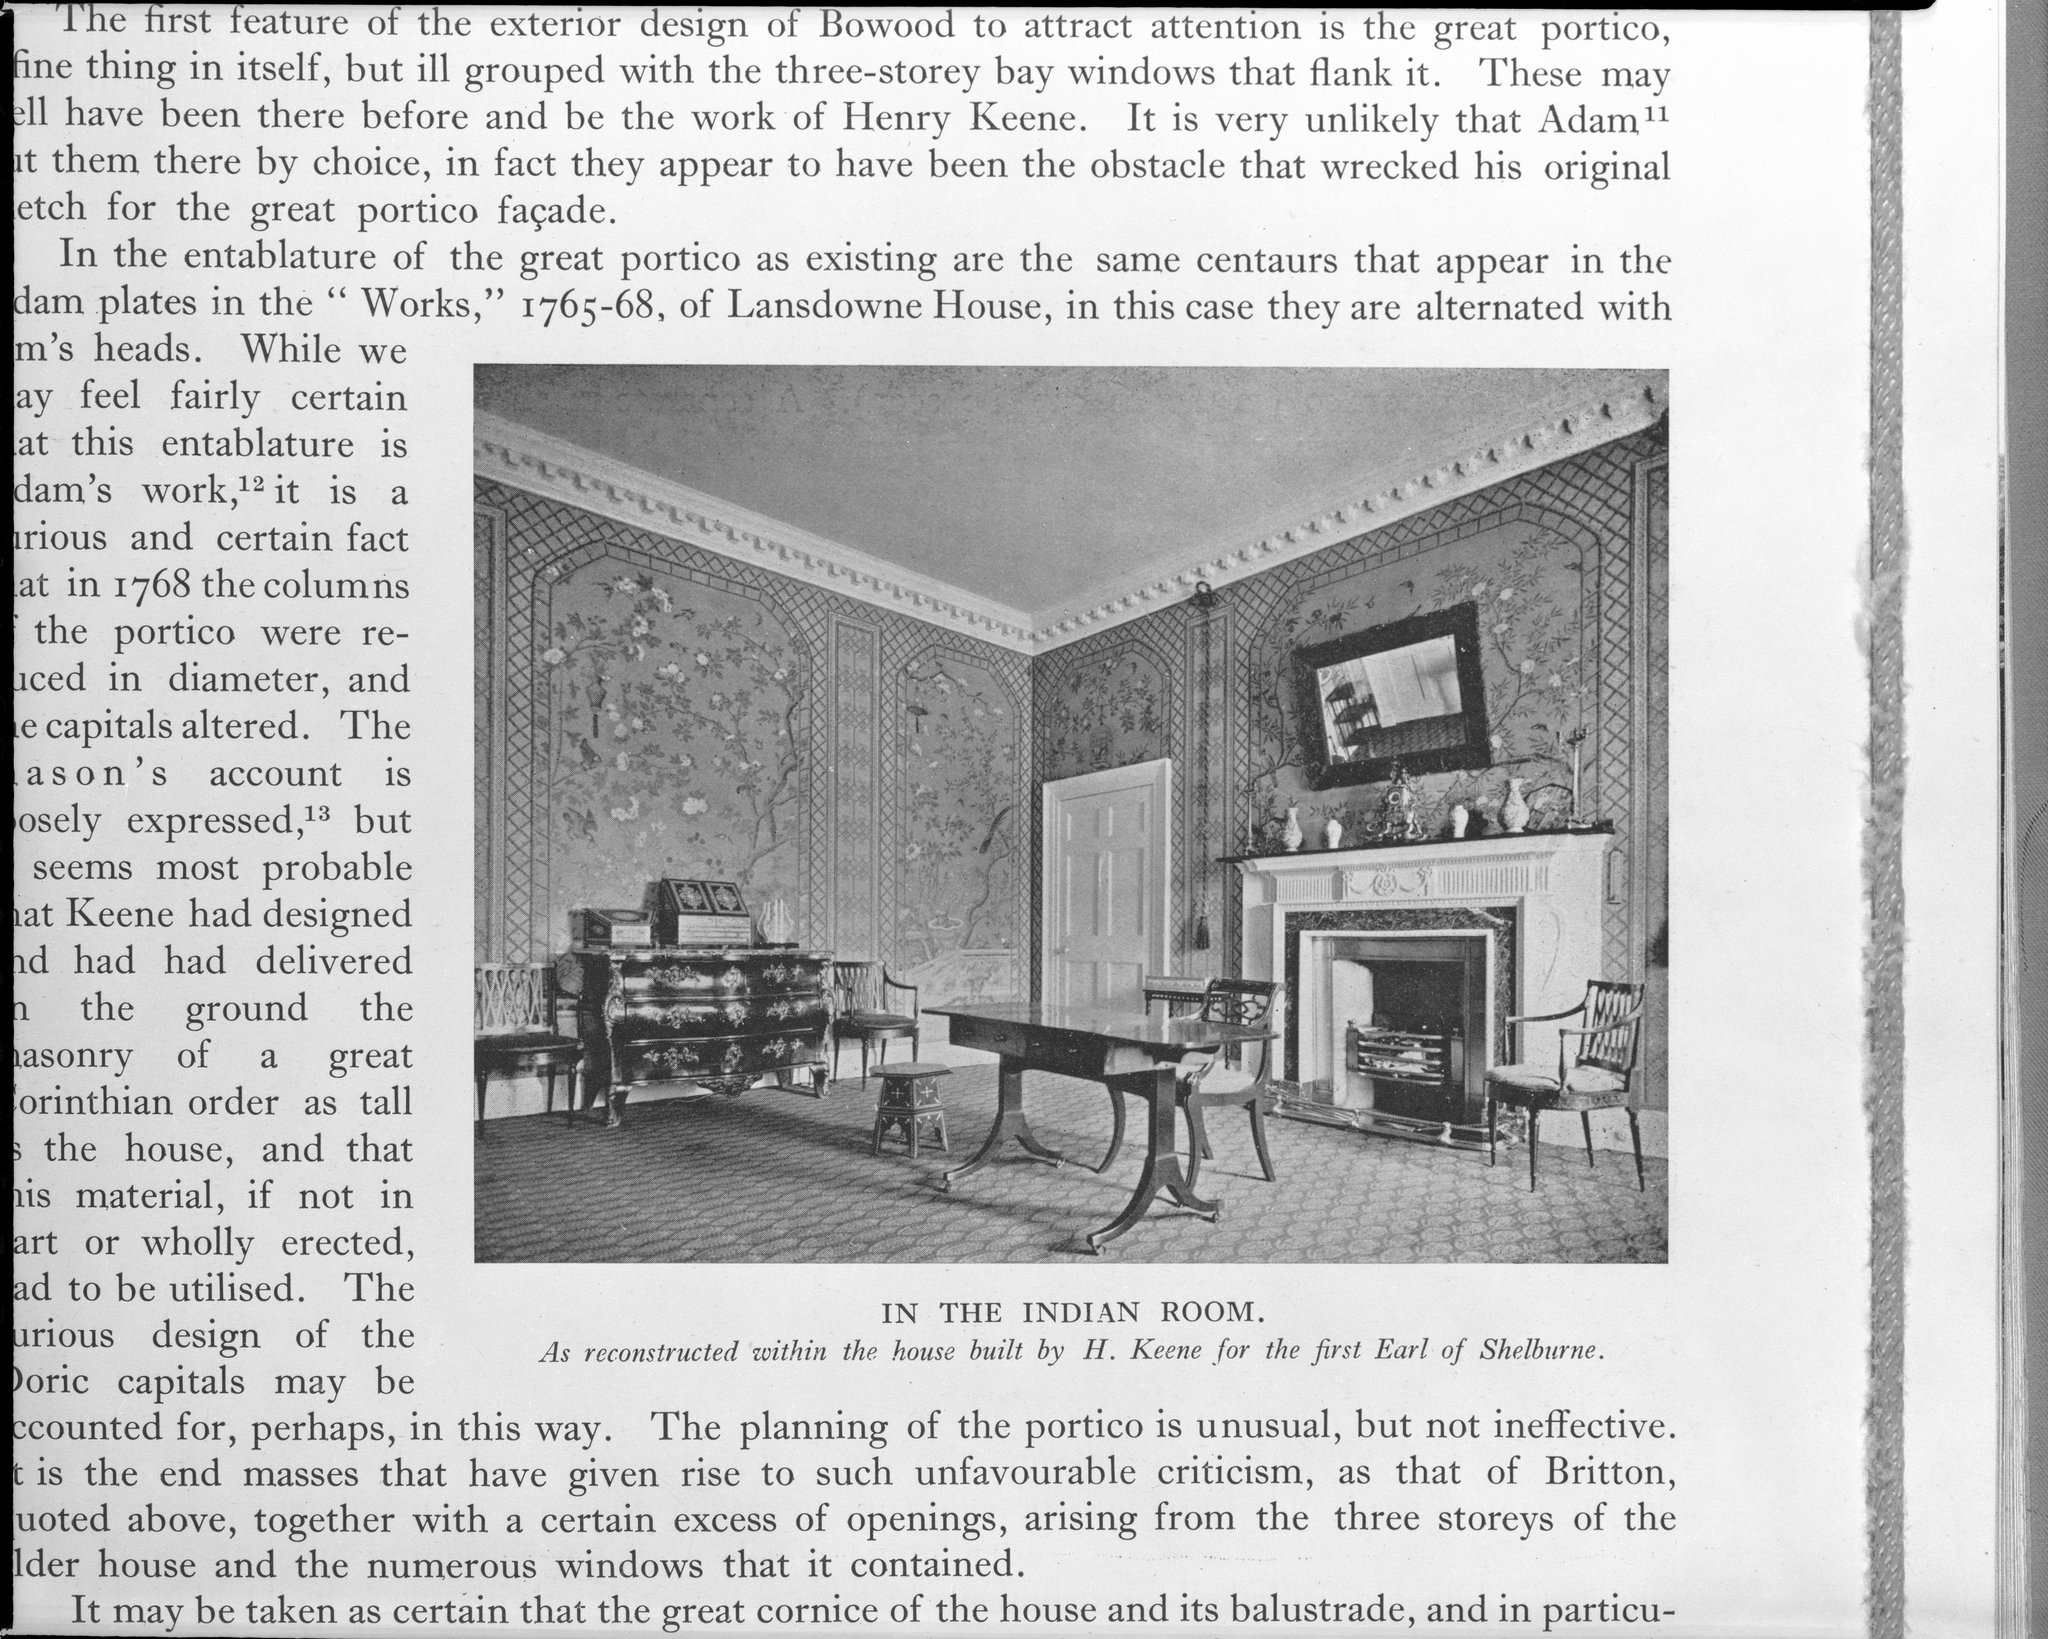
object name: wallpaper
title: Sixteen panels of wallpaper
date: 1734-1766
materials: paper